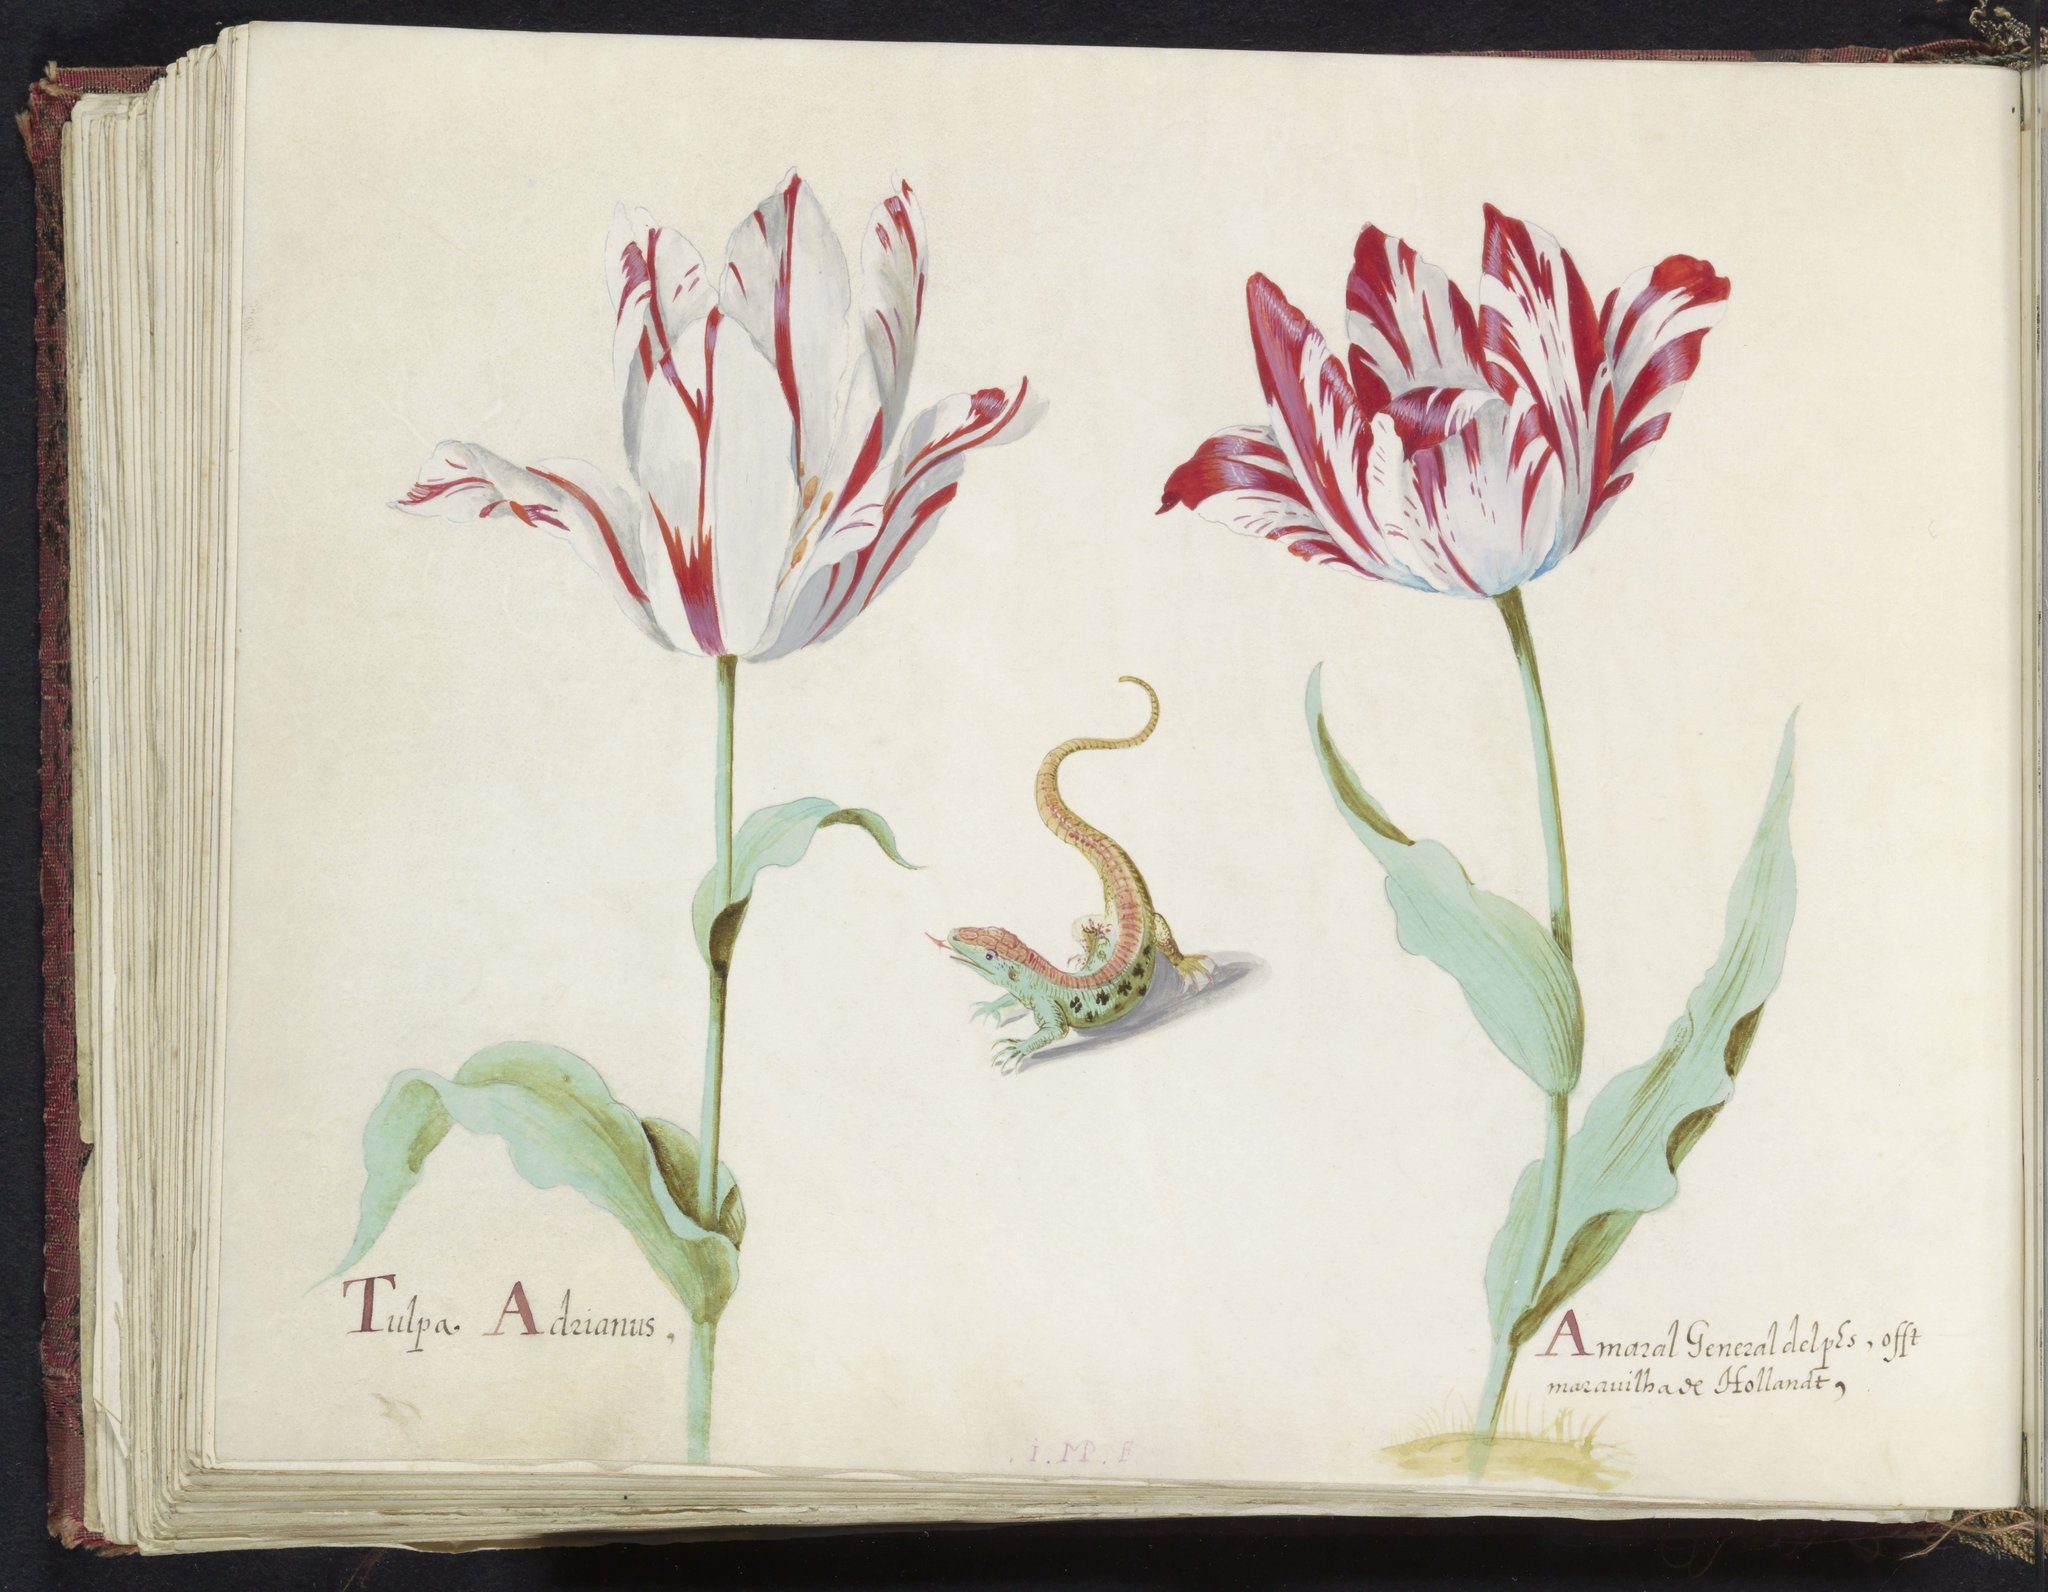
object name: album leaf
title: Twee tulpen met salamander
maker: jacob marrel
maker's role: draughtsman, painter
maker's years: 1614-1681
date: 1637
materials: paint, parchment, pencil, watercolor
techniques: brush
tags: salamander (fabulous animal); salamander as spirit of fire, flowers: tulip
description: De tekening maakt deel uit van een album.